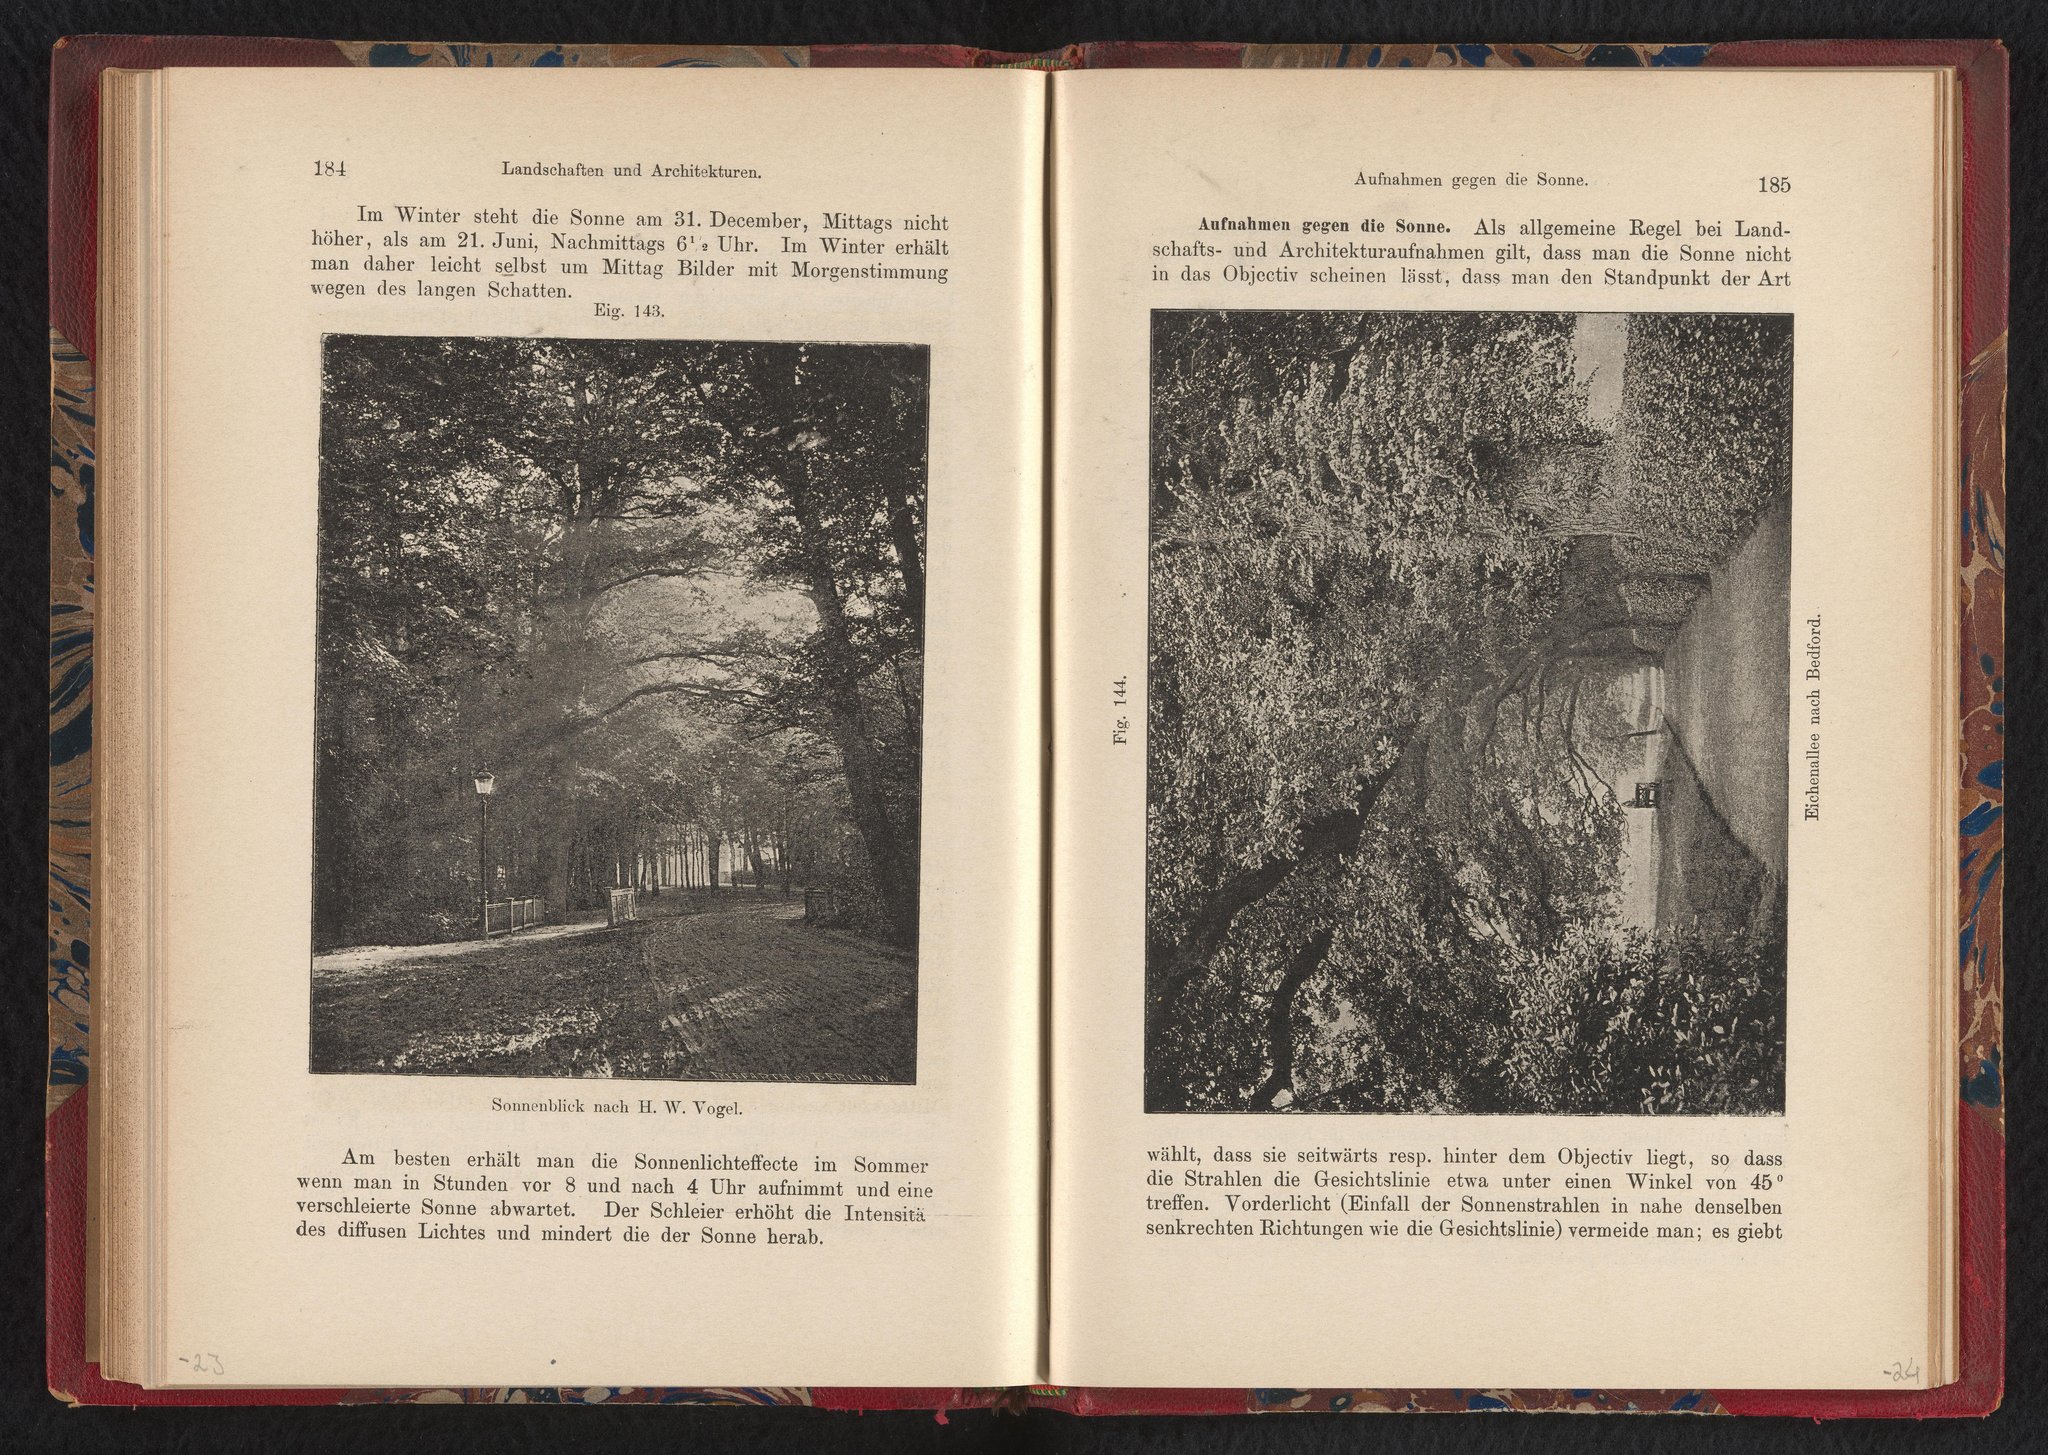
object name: page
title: Gezicht op een bospad met zitbank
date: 1886-1891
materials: paper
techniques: autotype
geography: berlin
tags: bench, forest path or lane